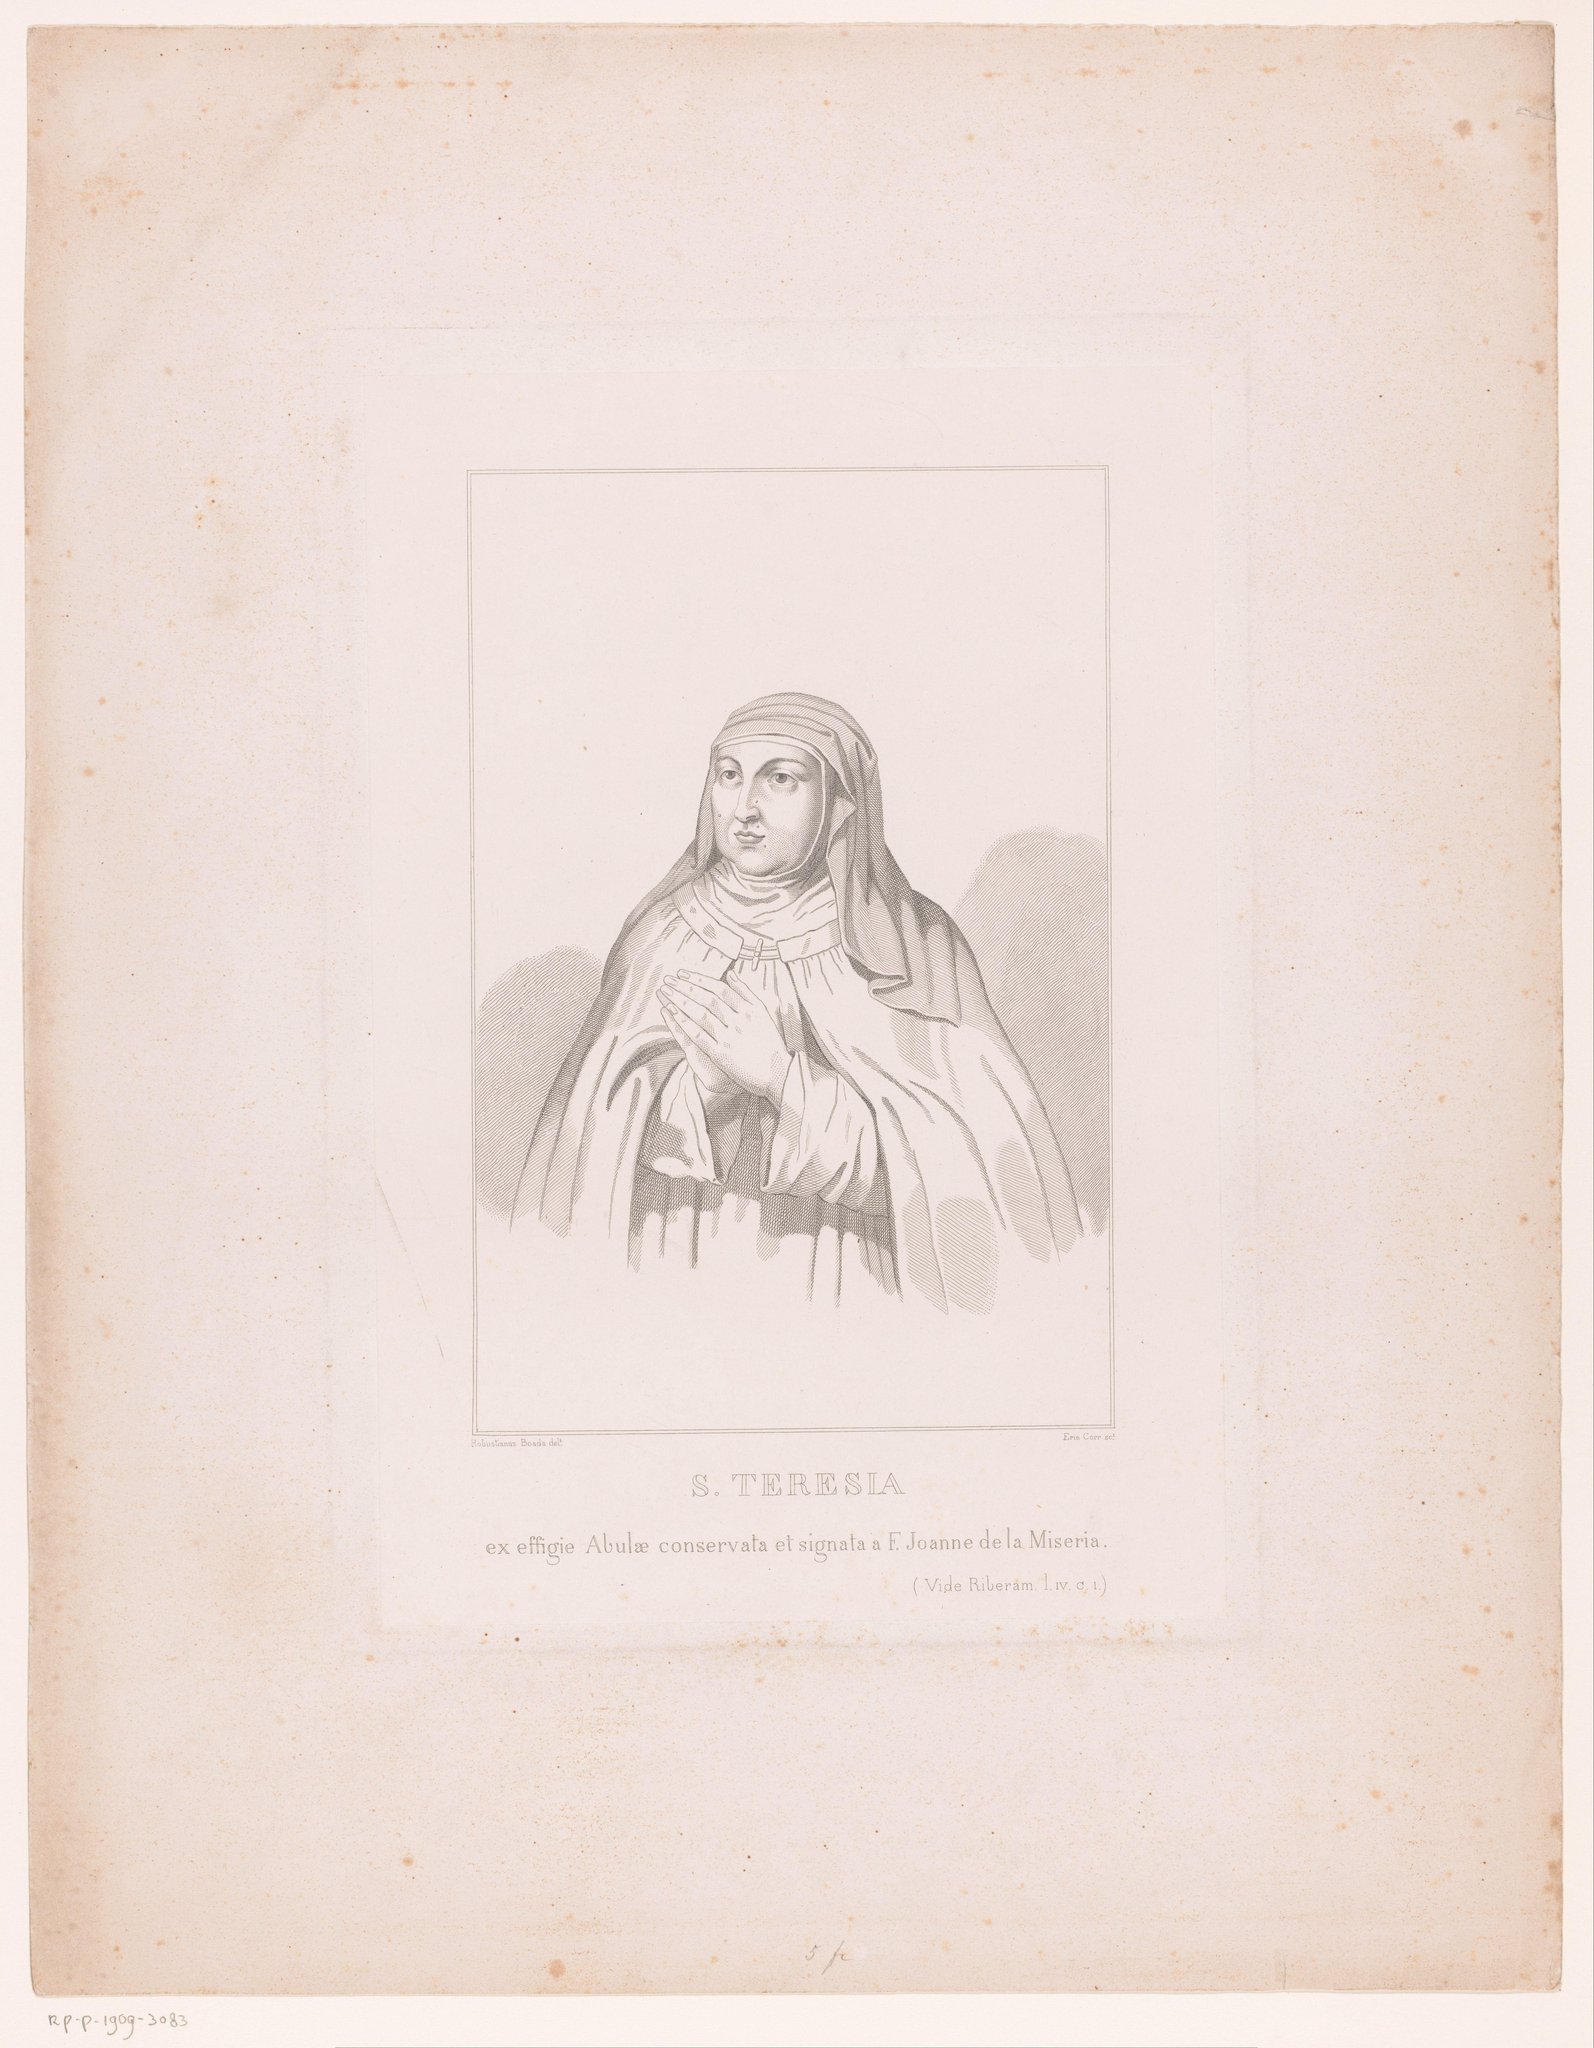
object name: print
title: S. Teresia ex effigie Abulae conservata et signata a F. Joanne de la Miseria (Vide Riberum L.IV.c.I.)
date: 1815-1862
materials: paper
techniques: engraving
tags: the foundress of the reformed (discalced) carmelites, t(h)eres(i)a of avila; possible attributes: angel, arrow, dove, heart (flaming or pierced by an arrow)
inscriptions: collector's mark: Lugt 2228